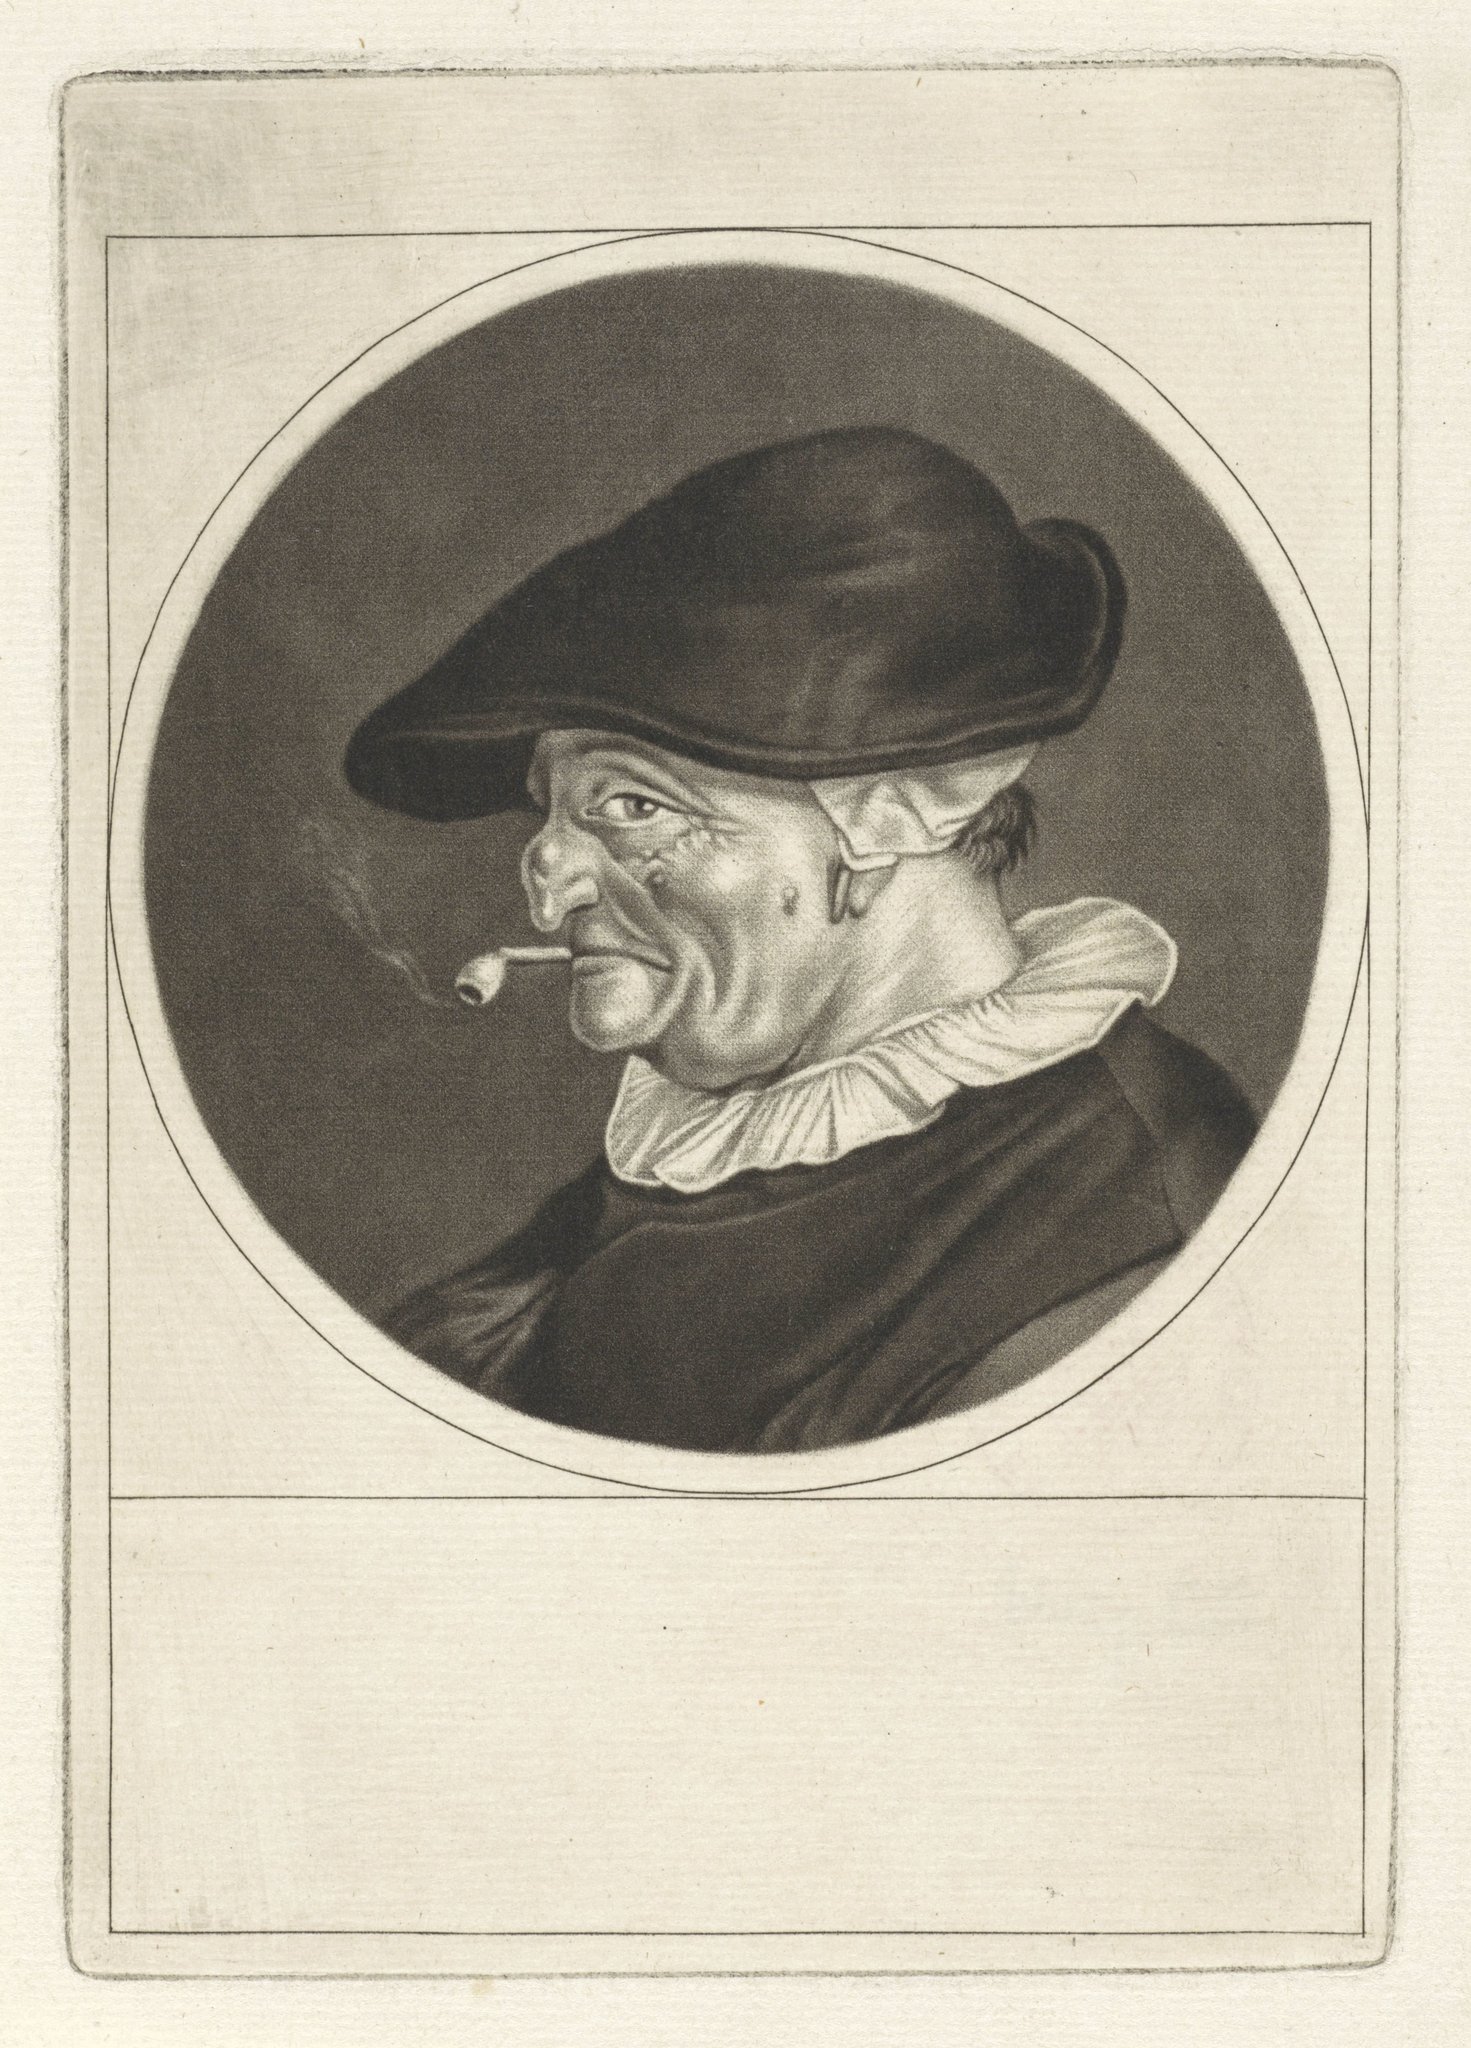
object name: print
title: Pijprokende vrouw (de Smaak)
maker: cornelis dusart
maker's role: draughtsman, painter, print maker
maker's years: 1660-1704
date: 1679-1704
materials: paper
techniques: engraving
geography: haarlem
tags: taste, tasting (one of the five senses), pipe ~ tobacco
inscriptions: collector's mark: Lugt 240